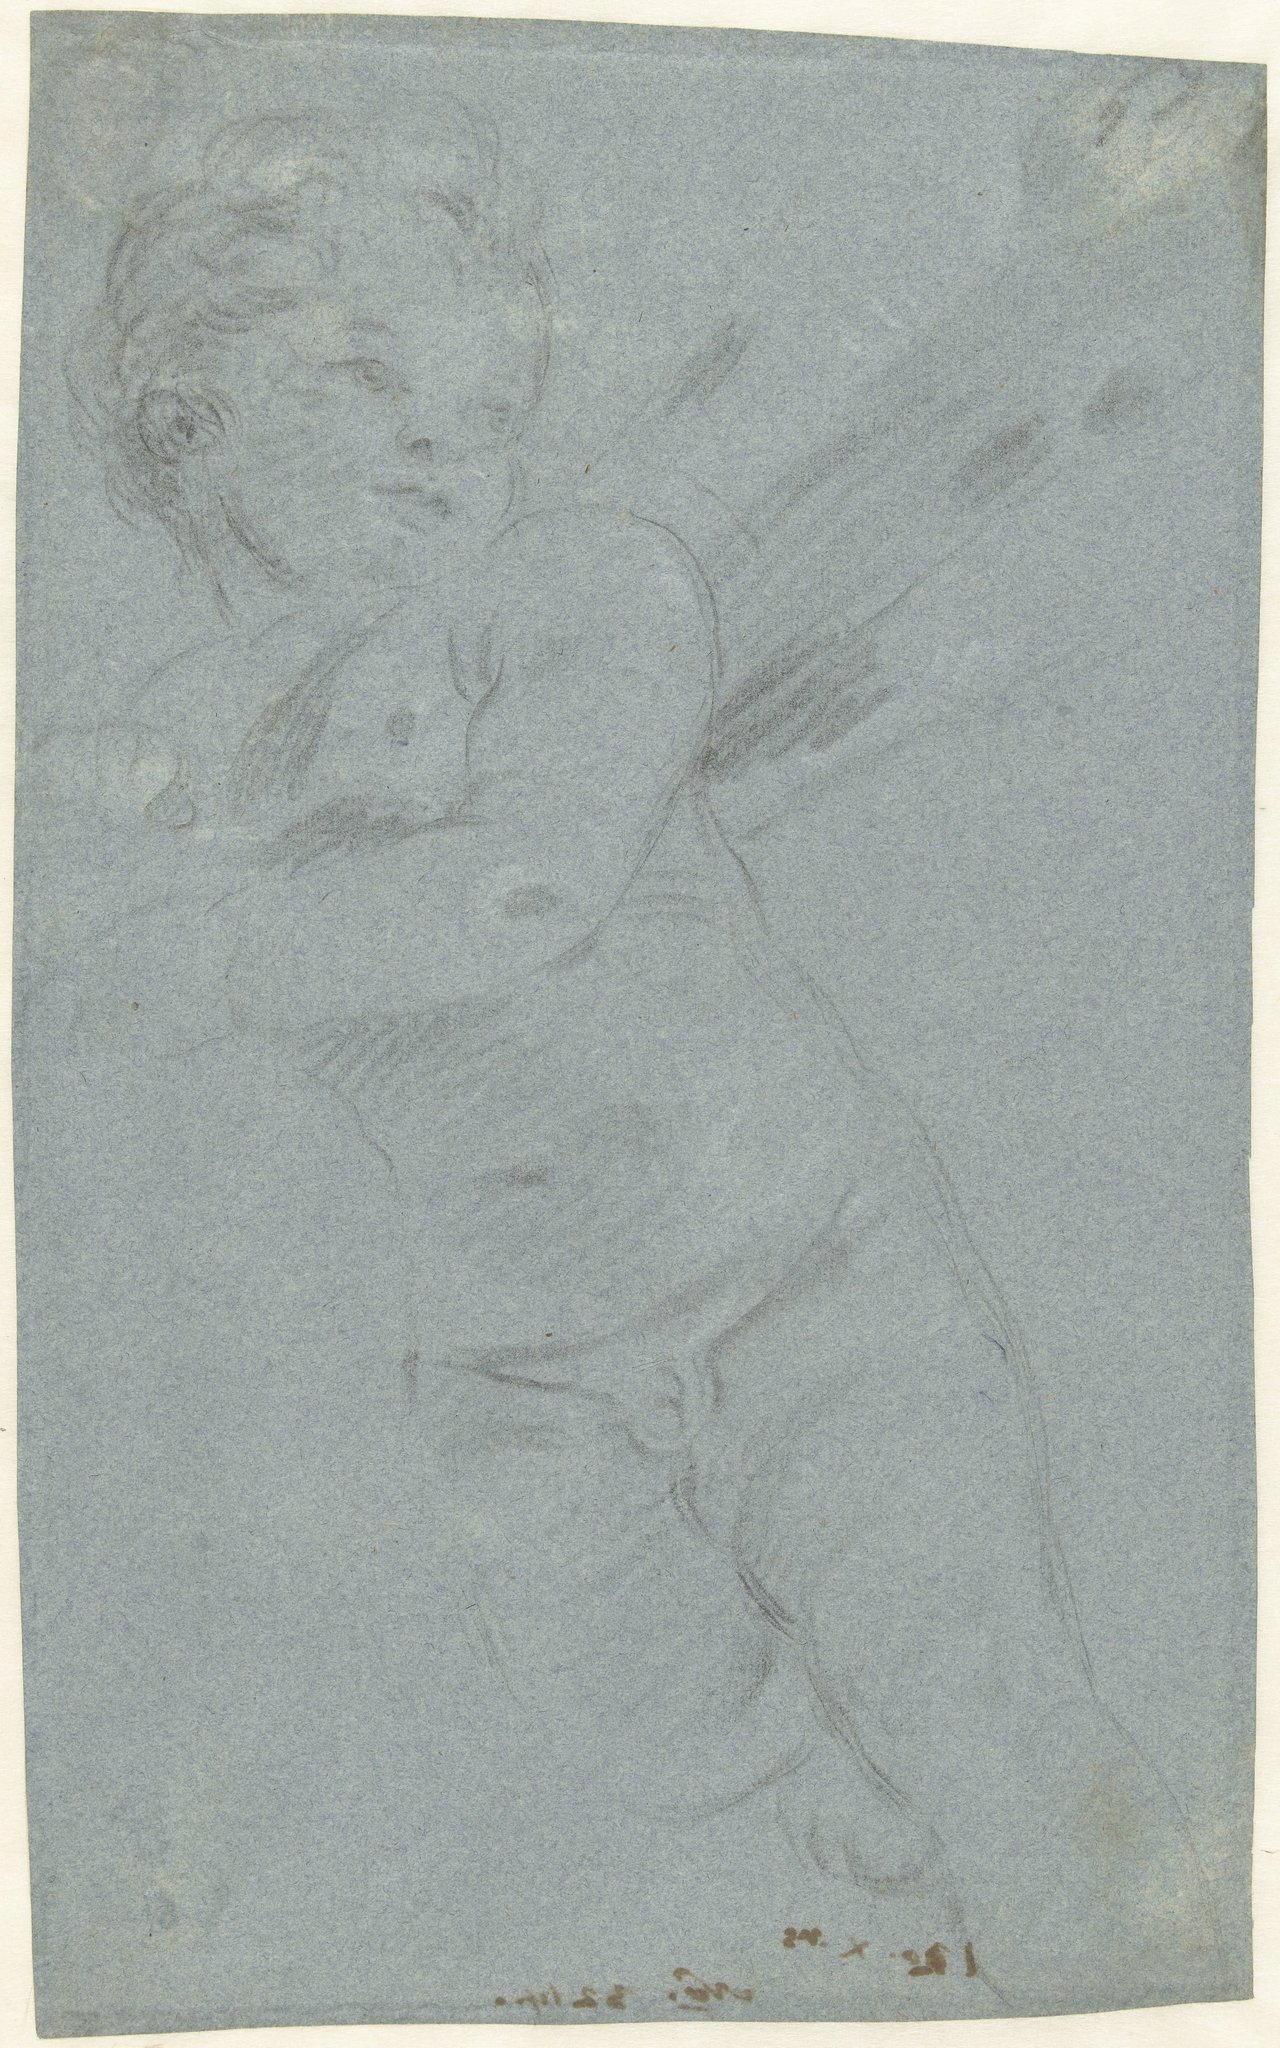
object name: drawing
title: Putto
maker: giovanni battista tiepolo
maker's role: draughtsman, painter, print maker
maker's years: 1696-1770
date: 1738-1743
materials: chalk, paper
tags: angel(s) represented as child(ren), cupids: 'amores', 'amoretti', 'putti'